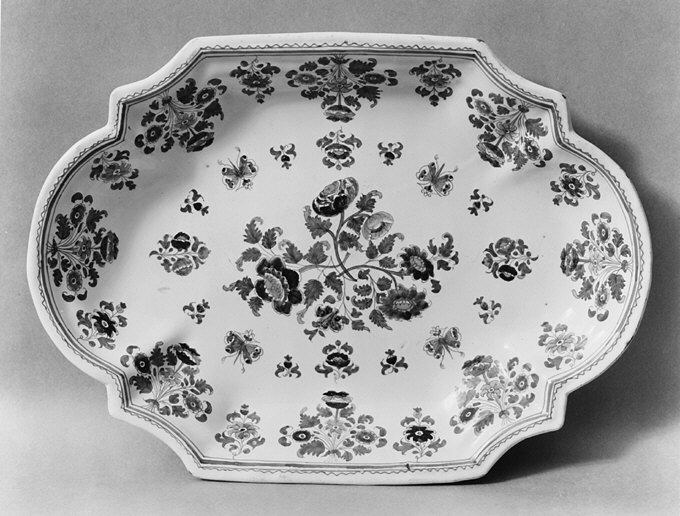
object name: platter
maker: olérys factory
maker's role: manufactory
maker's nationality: french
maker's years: 1738-1838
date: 1750-1770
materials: faience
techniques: glazing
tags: flowers